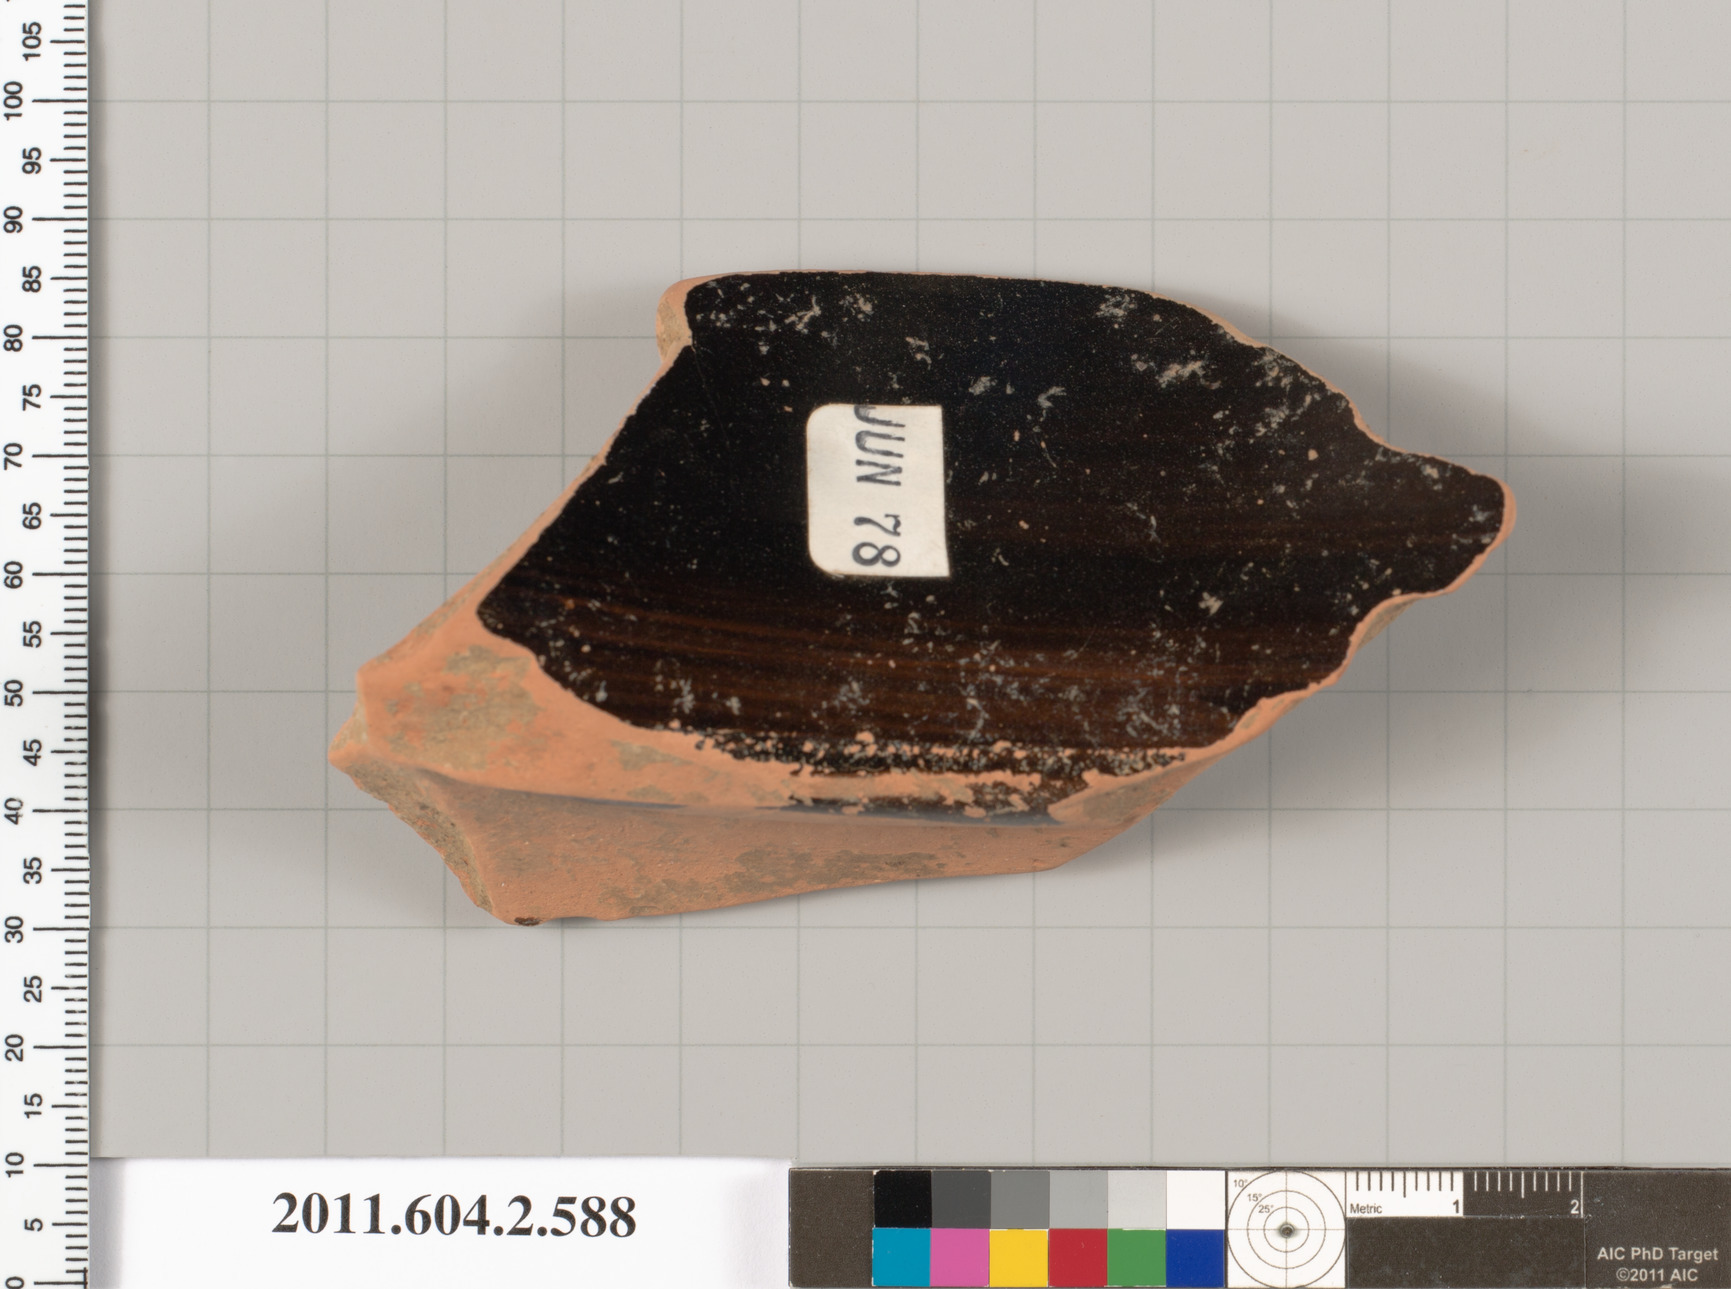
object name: column krater fragment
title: Terracotta fragment of a column-krater (bowl for mixing wine and water)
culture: greek, attic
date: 470-440 BCE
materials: terracotta